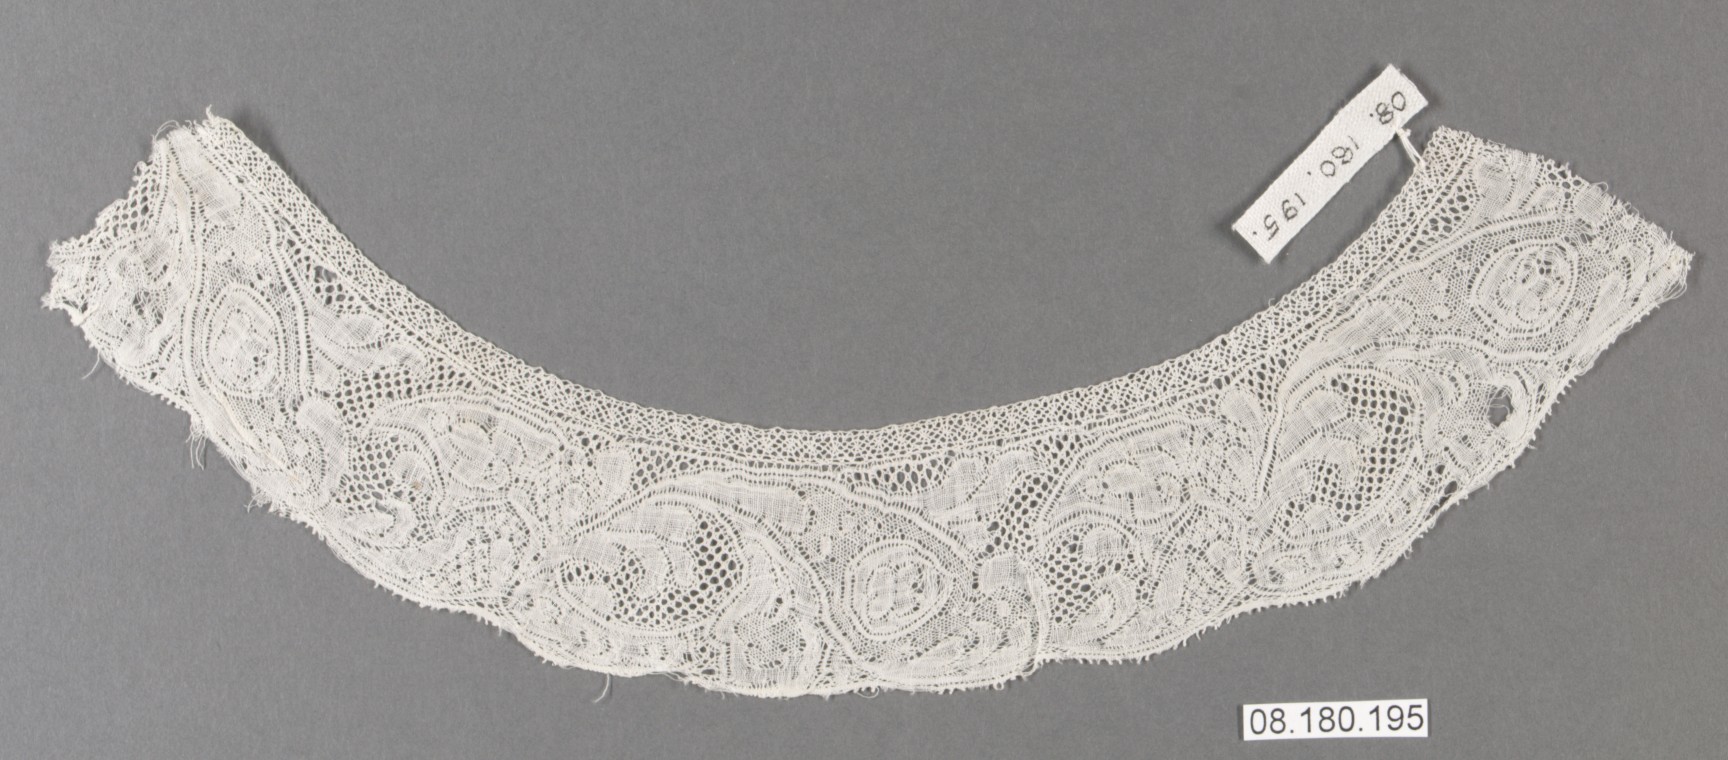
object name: collar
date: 1701-1733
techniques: lace